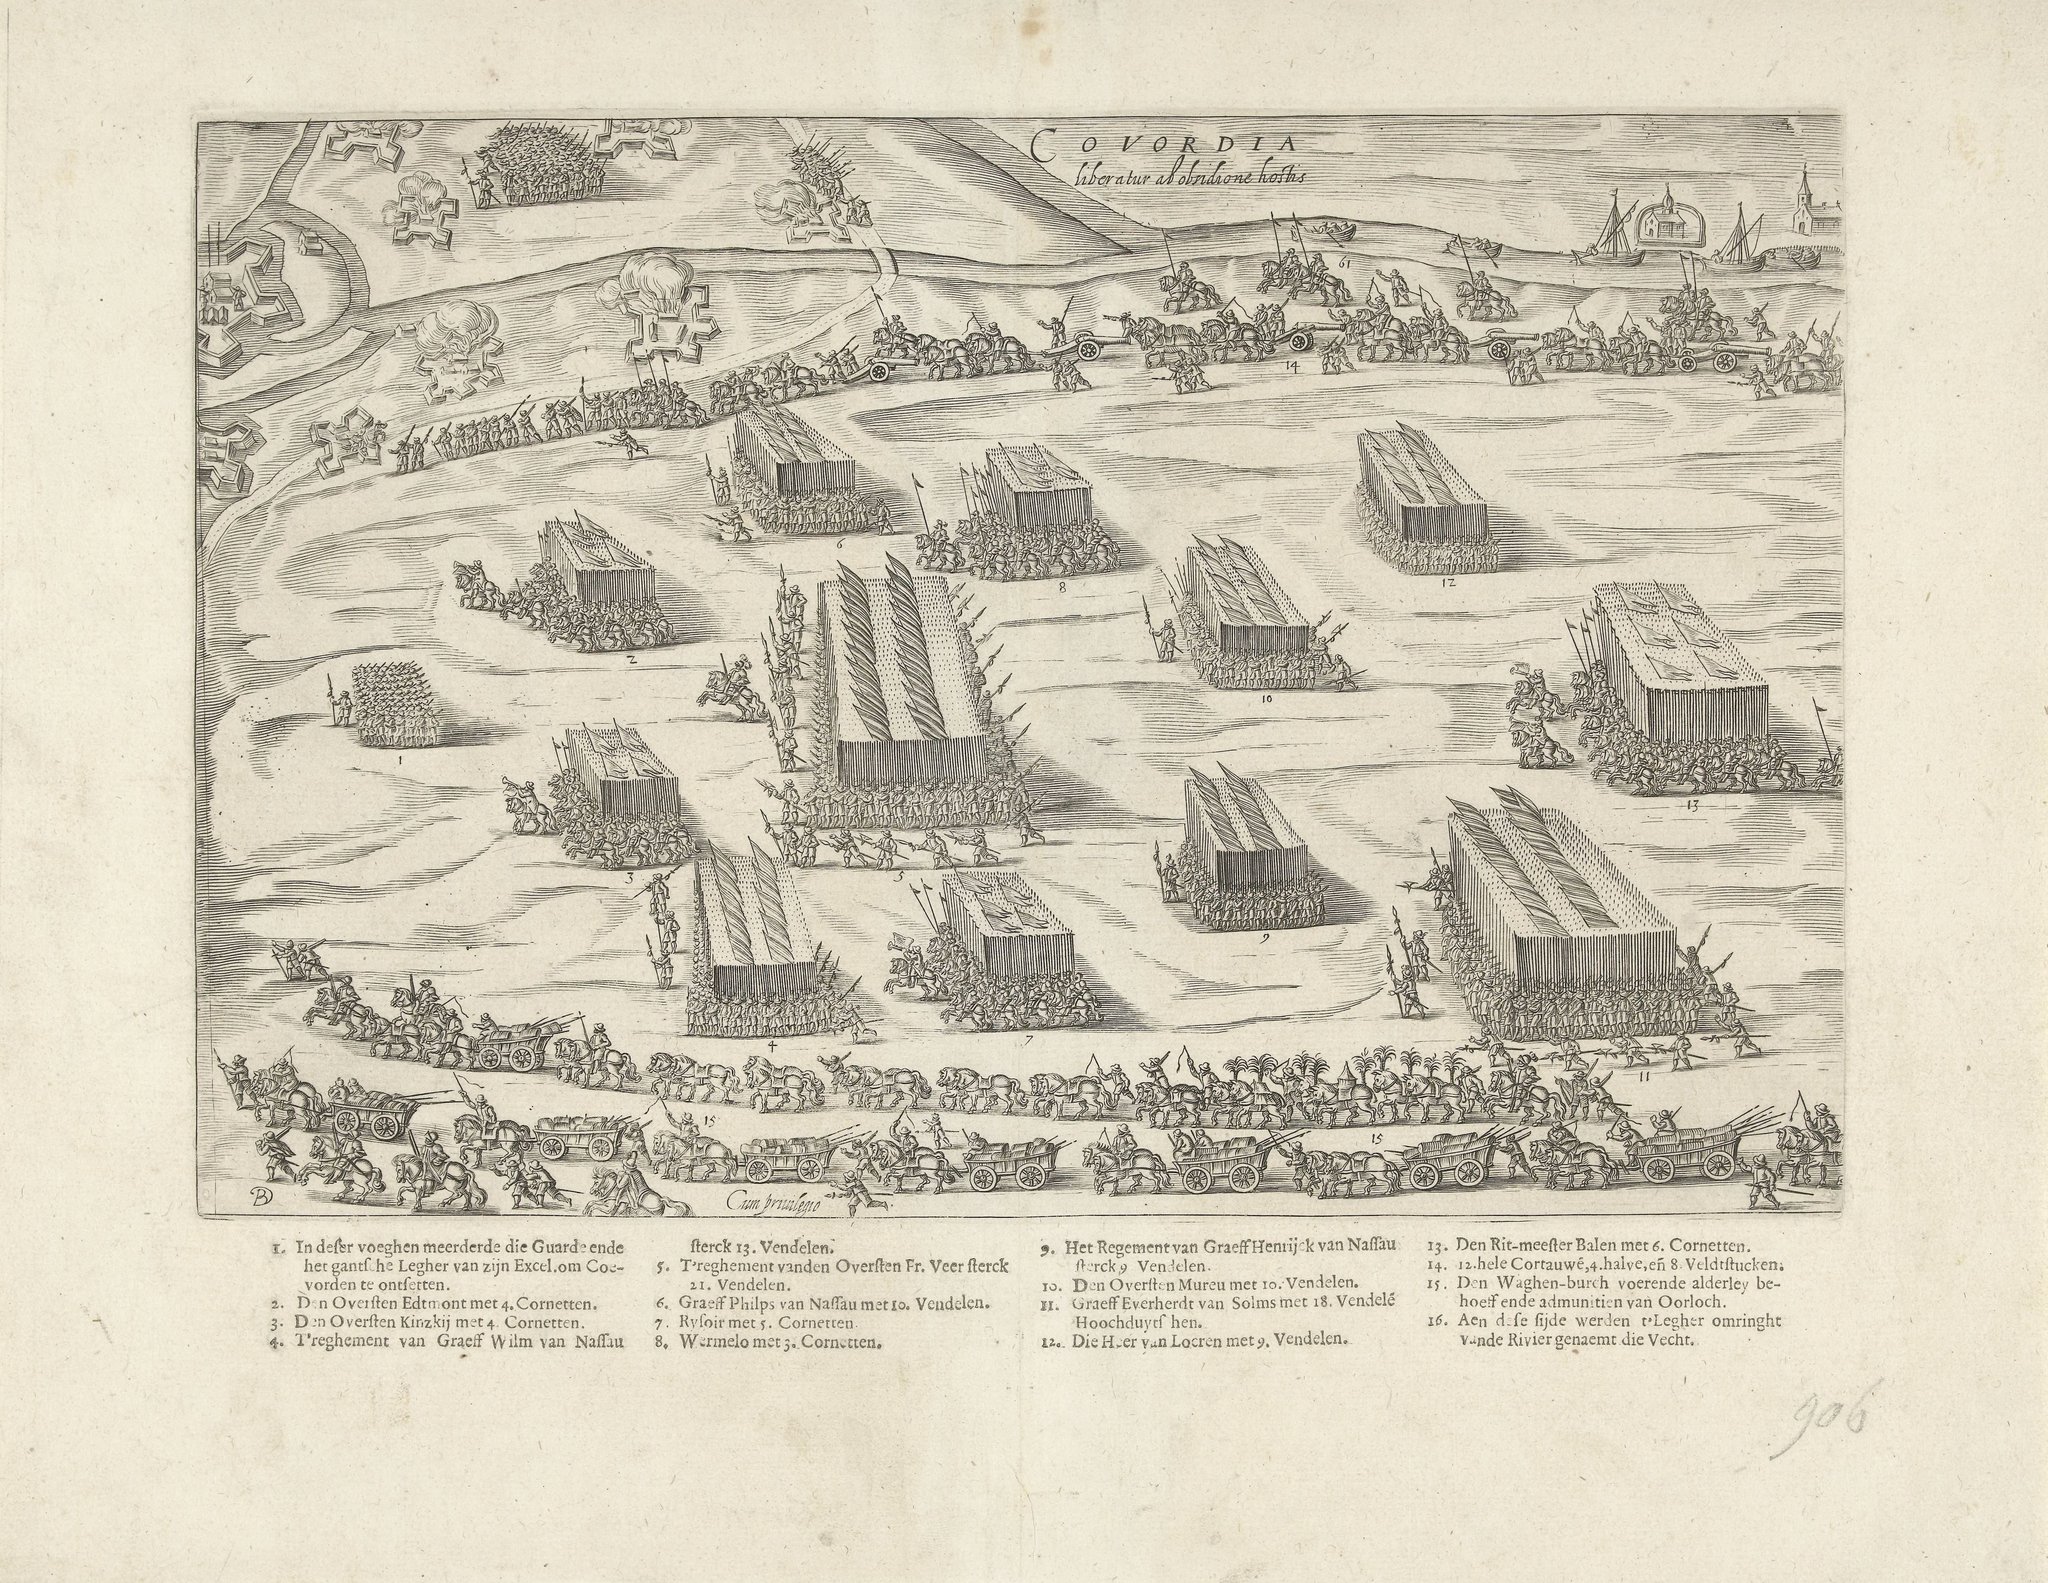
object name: print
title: Coevorden door Maurits ontzet, 1594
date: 1600-1601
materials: paper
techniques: engraving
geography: northern netherlands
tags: the hague, maurice (prince of orange), troop movements, transportation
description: Gebruikt als illustratie in: J.J. Orlers, Den Nassauschen Lauren-Crans: Beschrijvinghe ende af-beeldinge van alle de victorien ... die Godt Almachtich de ... Staten der Vereenichde Nederlanden verleent heeft, deur het wijs ende clouck beleyt des Hooch-ghebooren Fursts Maurits van Nassau, J.J. Orlers en H. van Haestens, Leiden 1610, fol. 96/97.